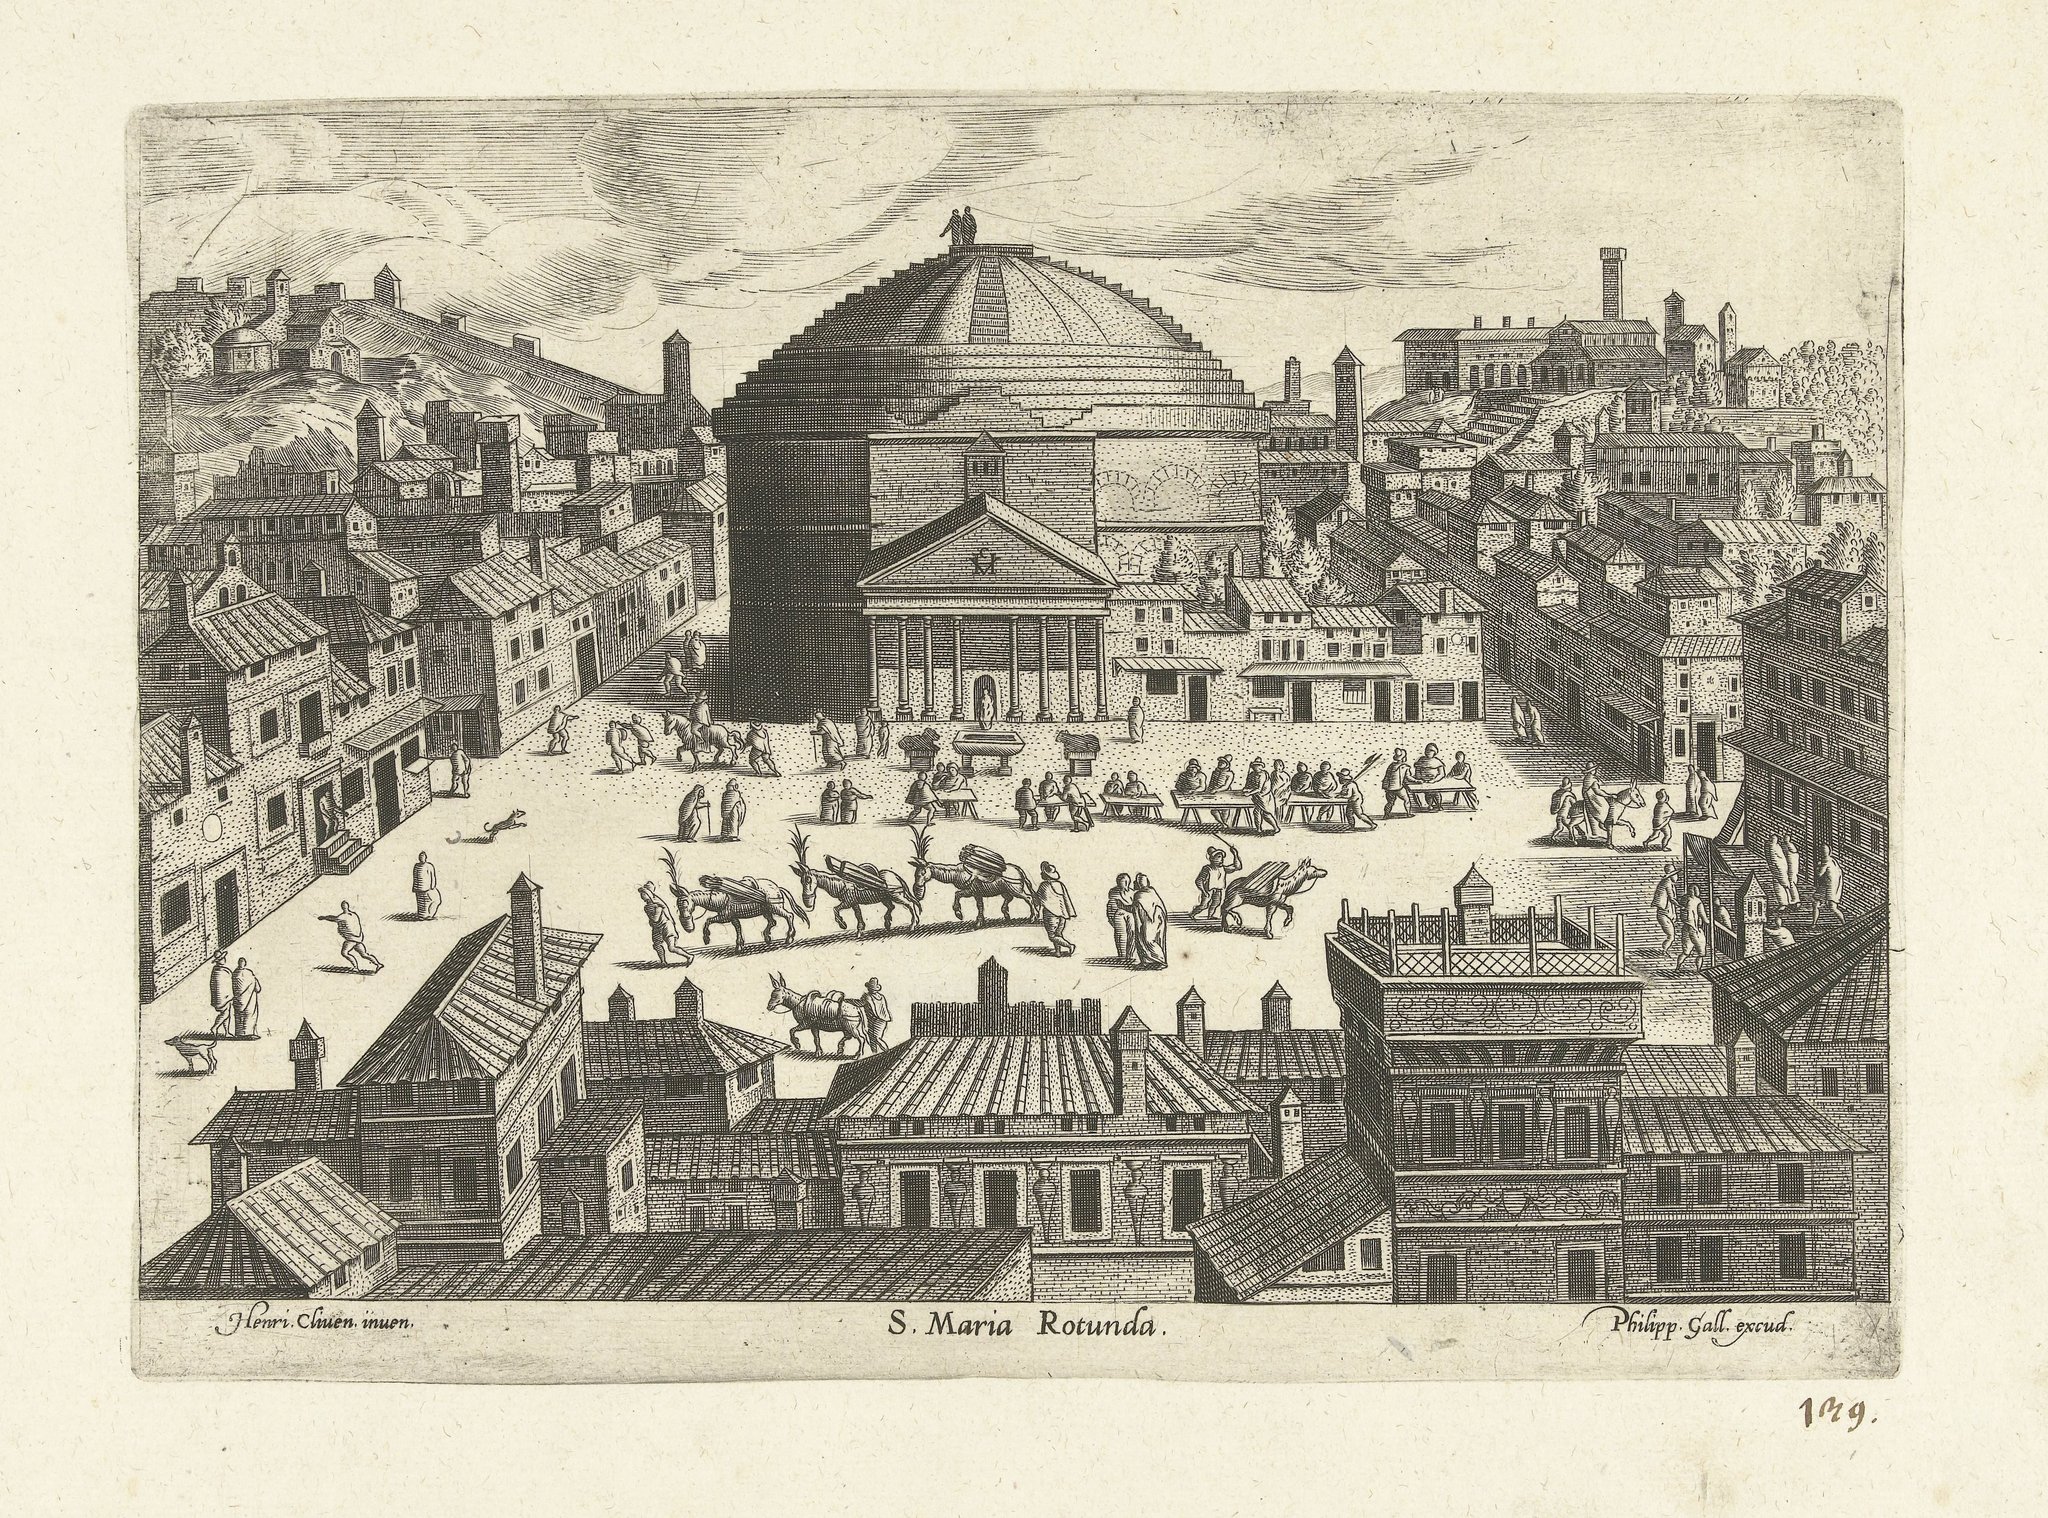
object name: print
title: Ruinarum varii prospectus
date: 1585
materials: paper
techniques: engraving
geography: antwerp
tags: city-view in general; 'veduta'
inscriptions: number: ‘139’, collector's mark: Lugt 2228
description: Gezicht op het Pantheon, de Romeinse tempel die in de zestiende eeuw bekend stond als Santa Maria dei Martiri. Op de voorgrond het Piazza della Rotonda met vele voetgangers. De prent is deel van een serie die verschillende plaatsen in het Middellandse Zeegebied afbeeldt.